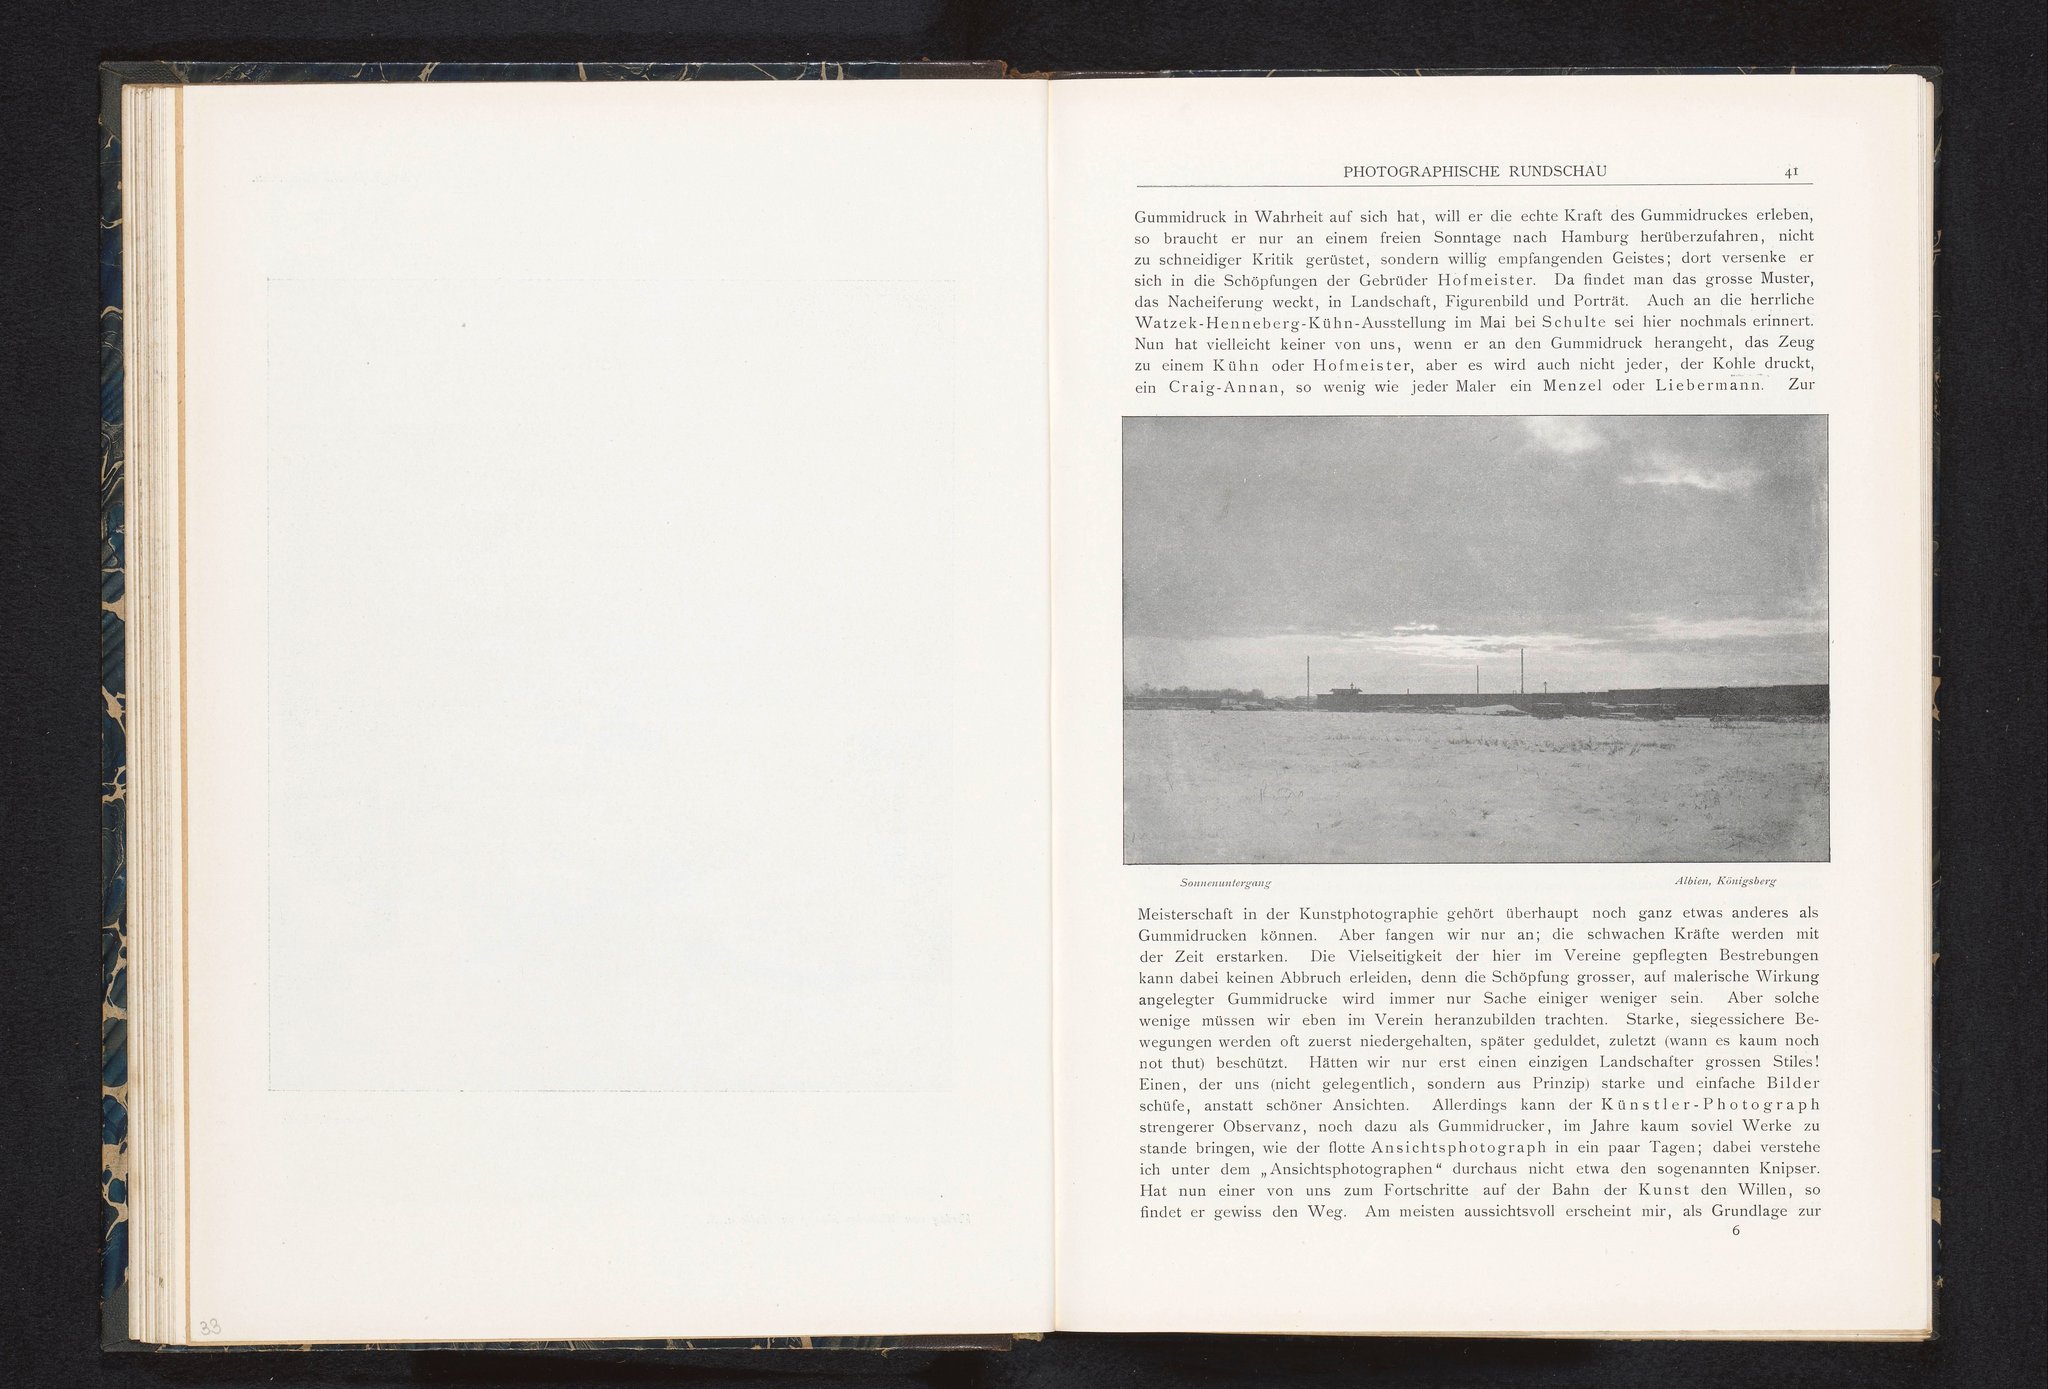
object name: page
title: Sonnenuntergang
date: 1896-1901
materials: paper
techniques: autotype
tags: landscapes, sunset